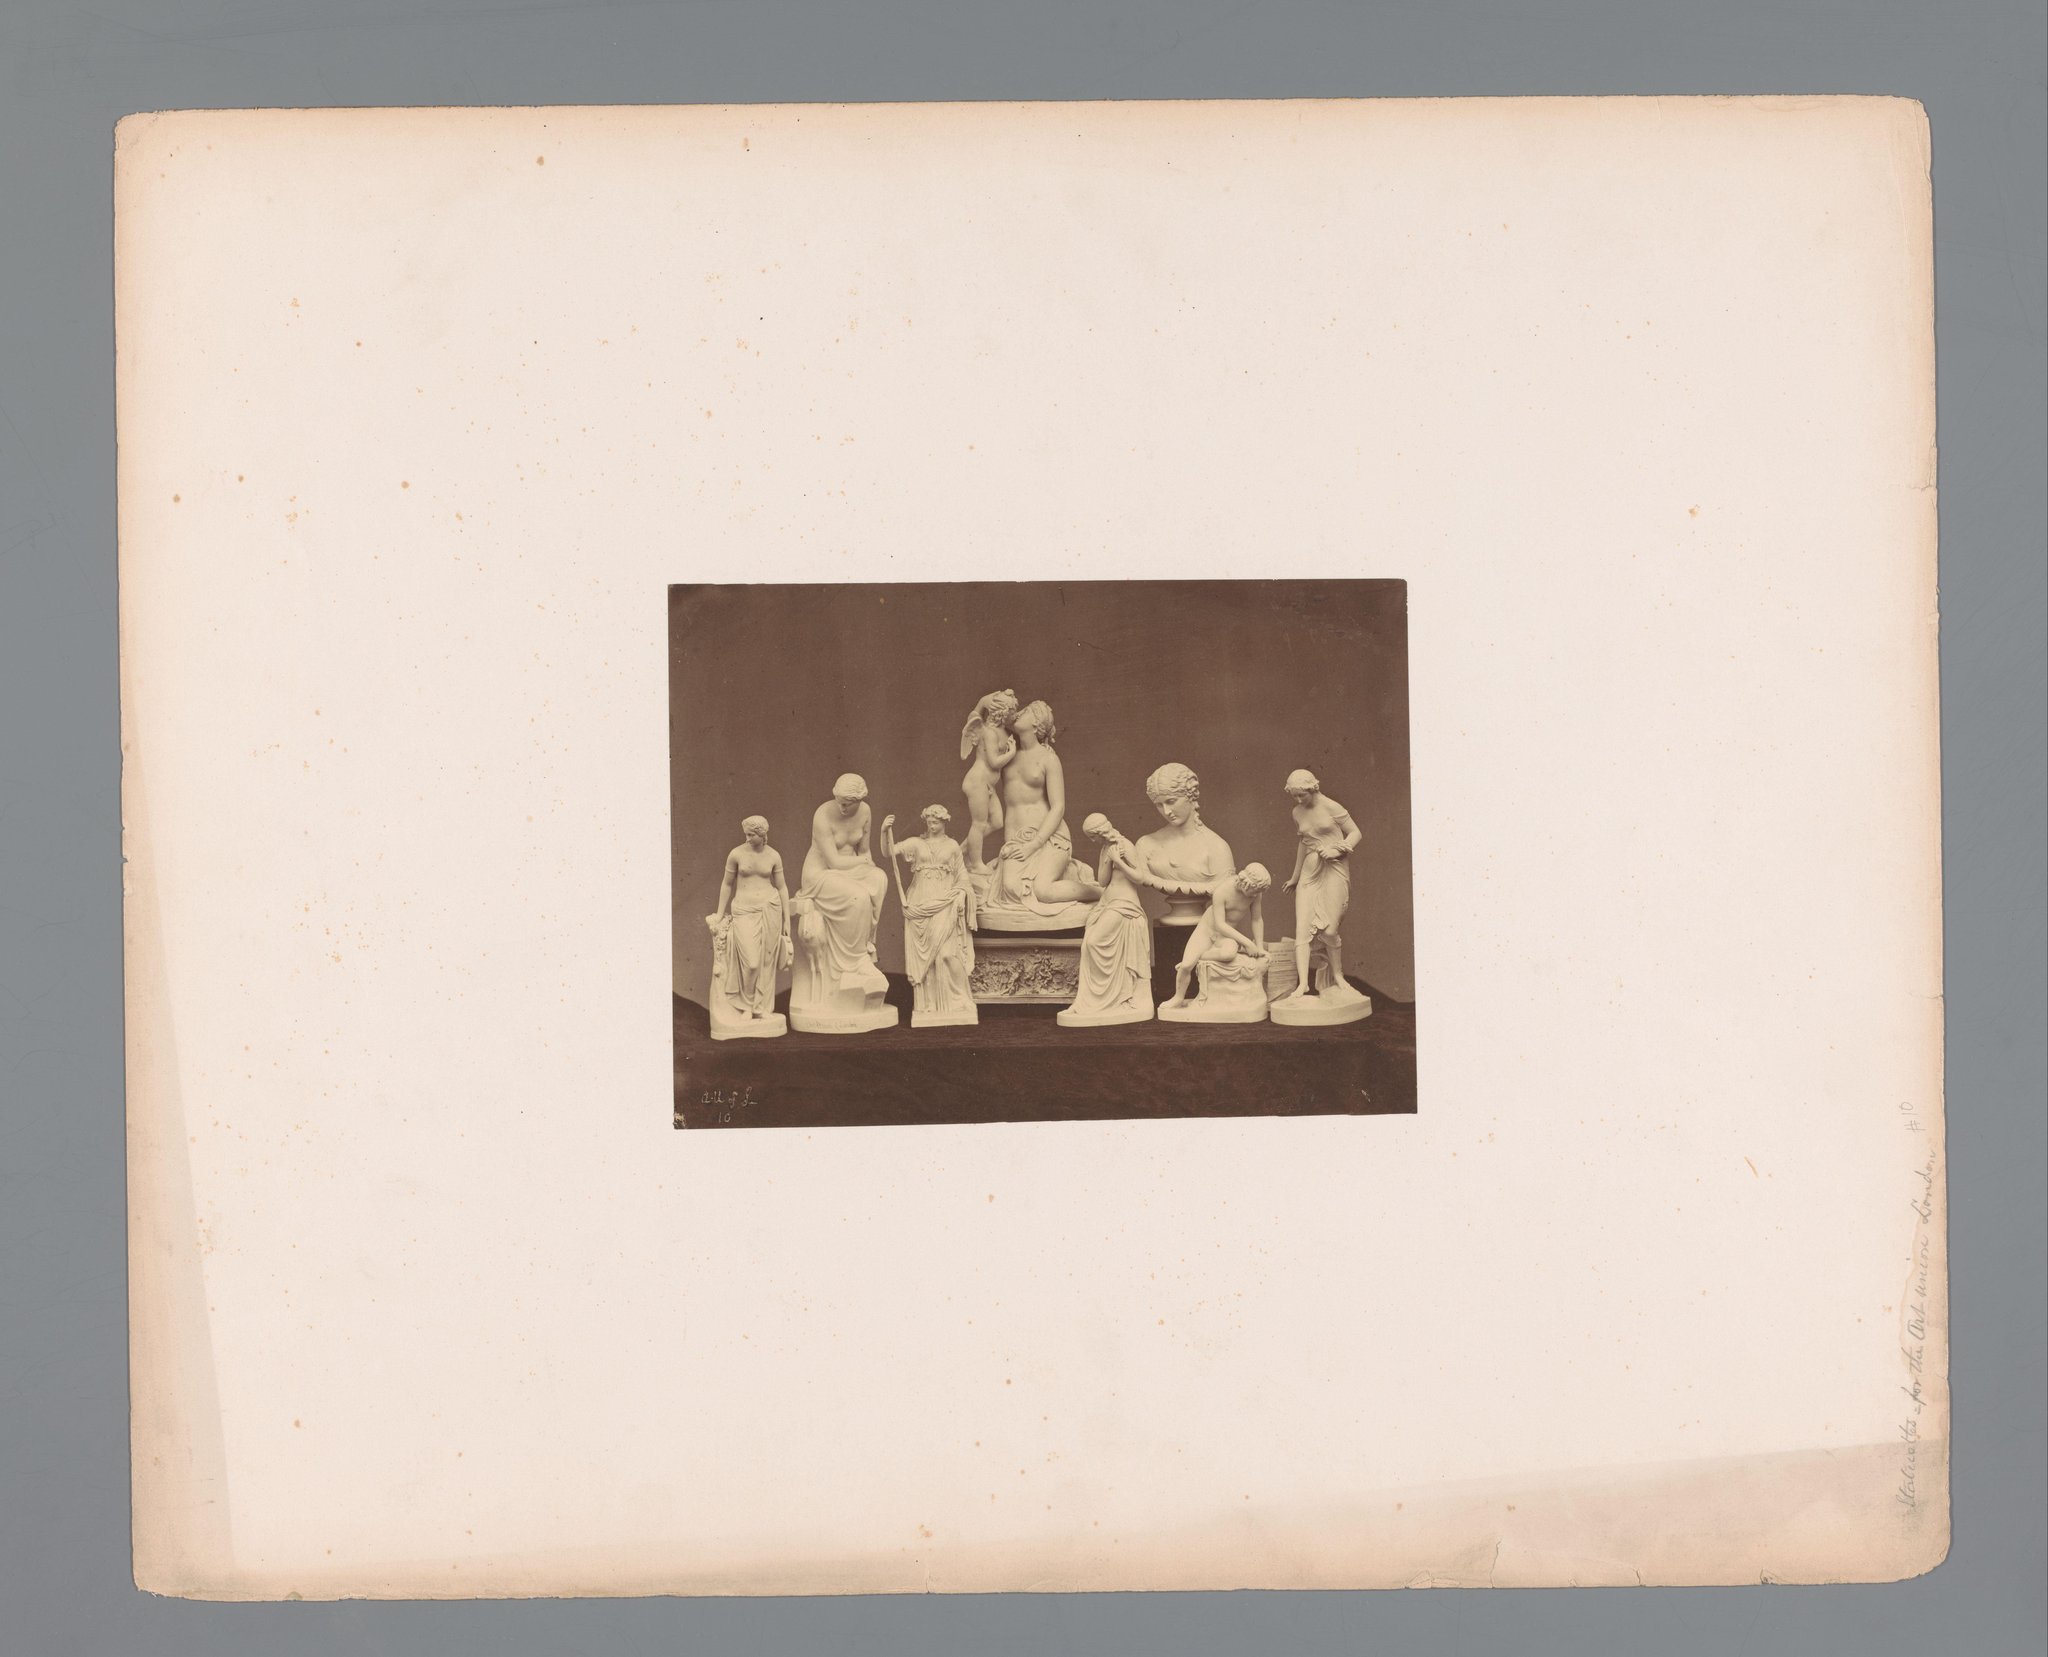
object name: photograph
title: Opstelling van acht sculpturen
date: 1853-1858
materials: photographic support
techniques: albumen print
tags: piece of sculpture, reproduction of a piece of sculpture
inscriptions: annotation: ‘Statuettes for the Art Union of London #10’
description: Deze foto maakt deel uit van een omslag met acht foto's, twee tekstbladen en een dekblad.